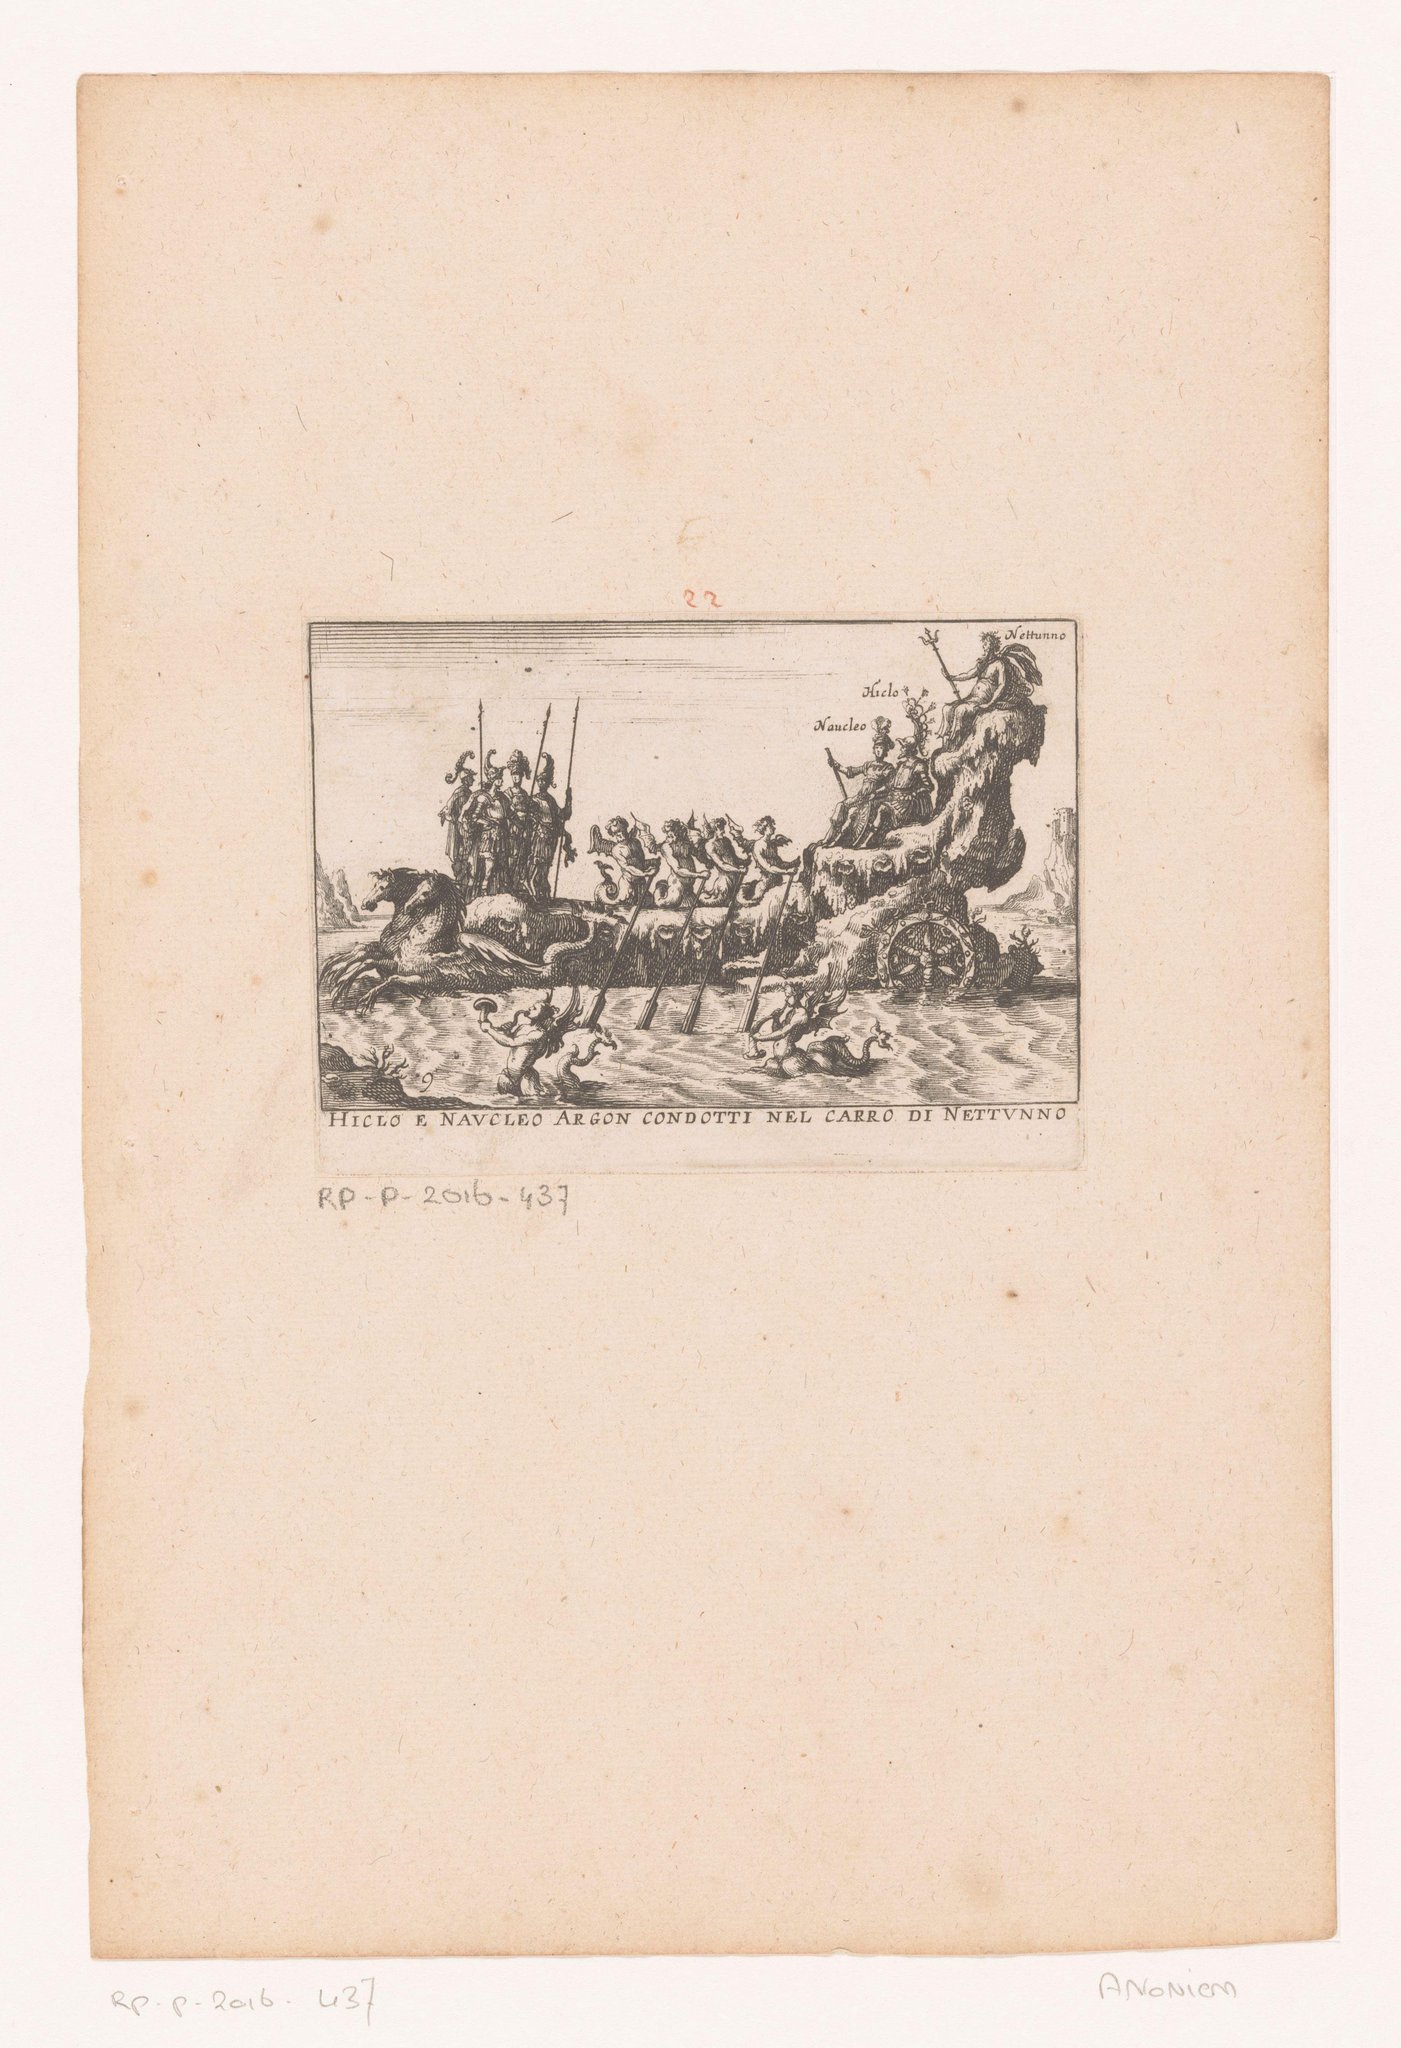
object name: print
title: Schip met Hylas, Nauplius en Neptunus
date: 1624-1631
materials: paper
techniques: etching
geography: paris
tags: (story of) neptune (poseidon), ships (in general), the story of the argonauts: the quest for the golden fleece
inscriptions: collector's mark: Lugt 2228, number: ‘22’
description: Een schip met twee zeepaarden als boegbeelden, met roeiende meermannen. Op het achtersteven zitten Nauplius, Hylas en Neptunus.